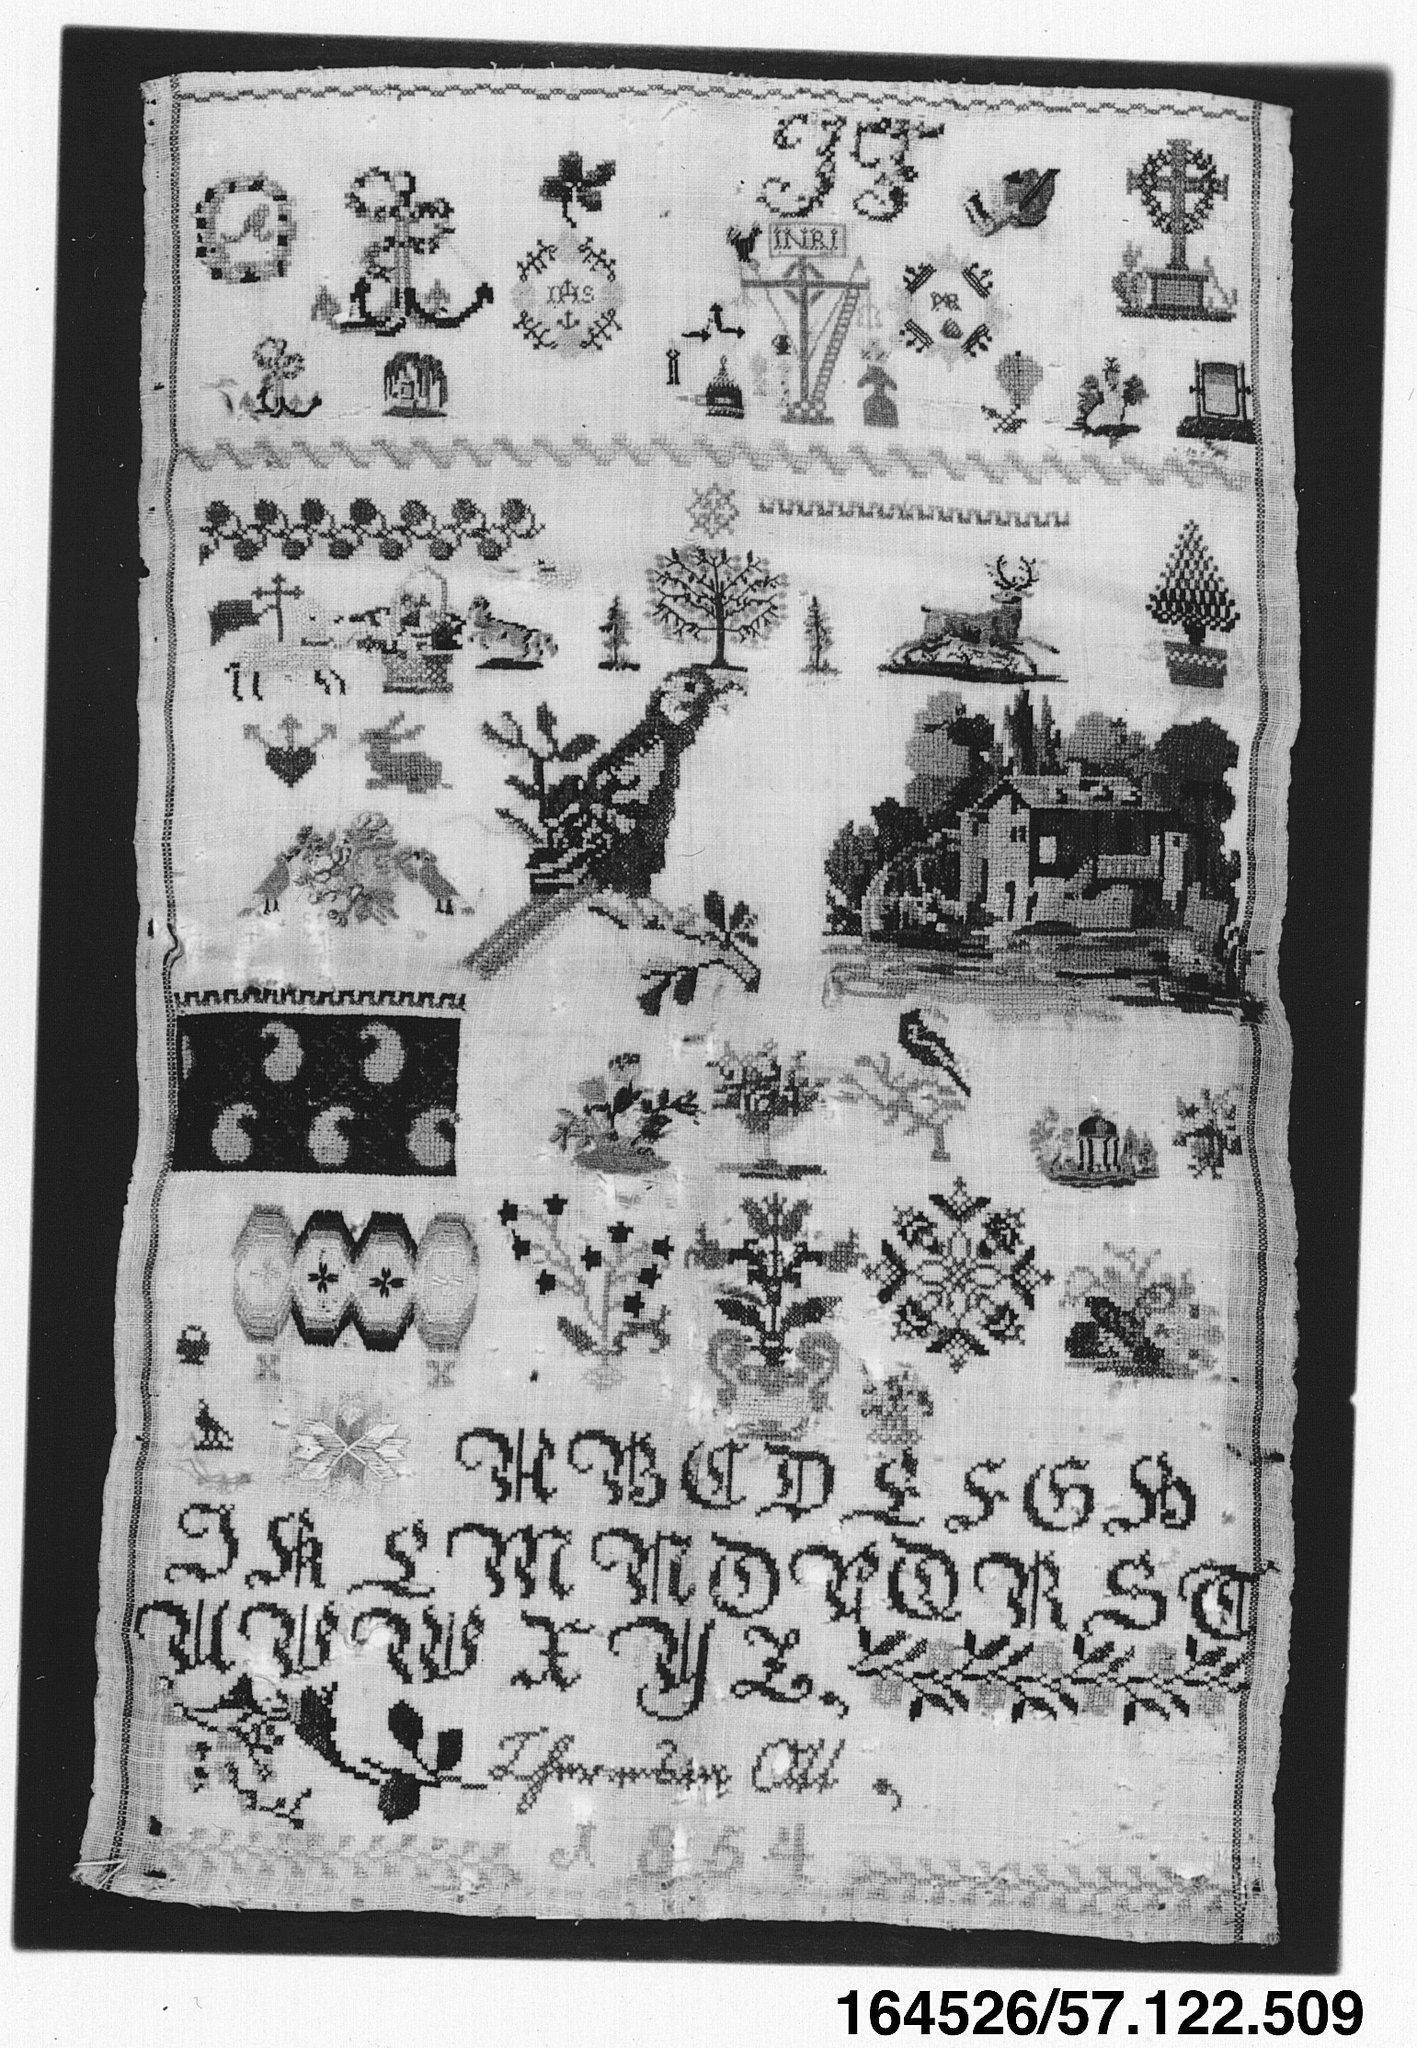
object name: sampler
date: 1854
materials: canvas, silk, wool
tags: birds,houses,flowers